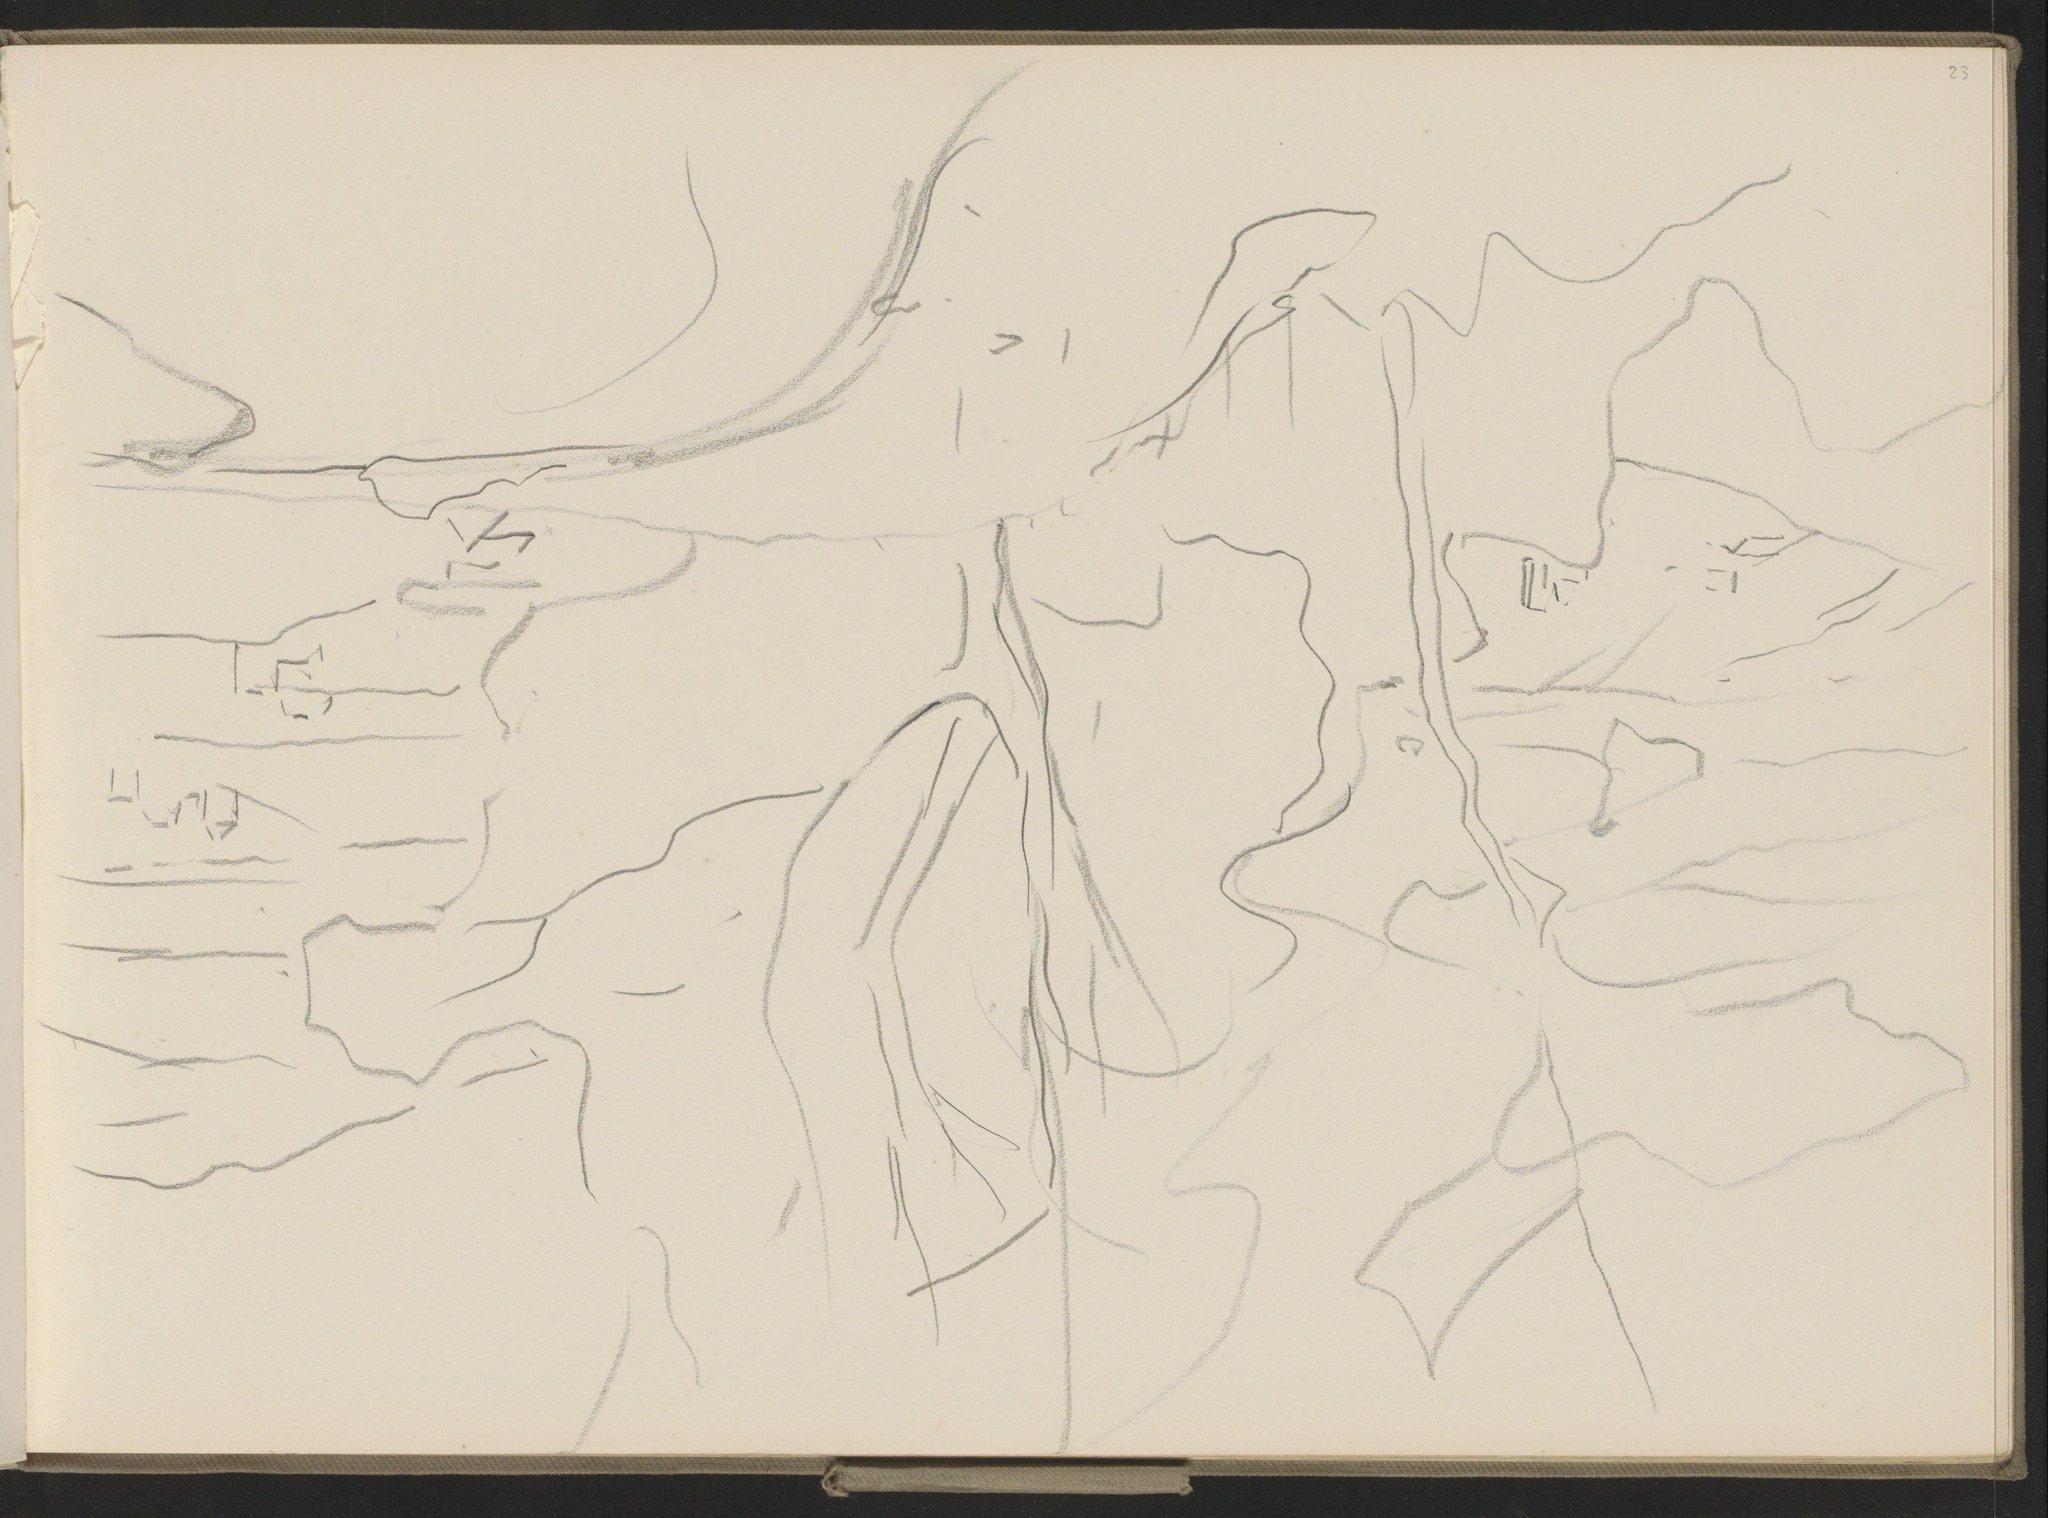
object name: sketchbook leaf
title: Heuvellandschap met bebouwing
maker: willem witsen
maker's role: draughtsman, painter, print maker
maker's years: 1860-1923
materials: paper, pencil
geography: italy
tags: low hill country, rural housing, e.g. country-house, villa, cottage, italy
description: Pagina 23 uit een schetsboek met 32 bladen.